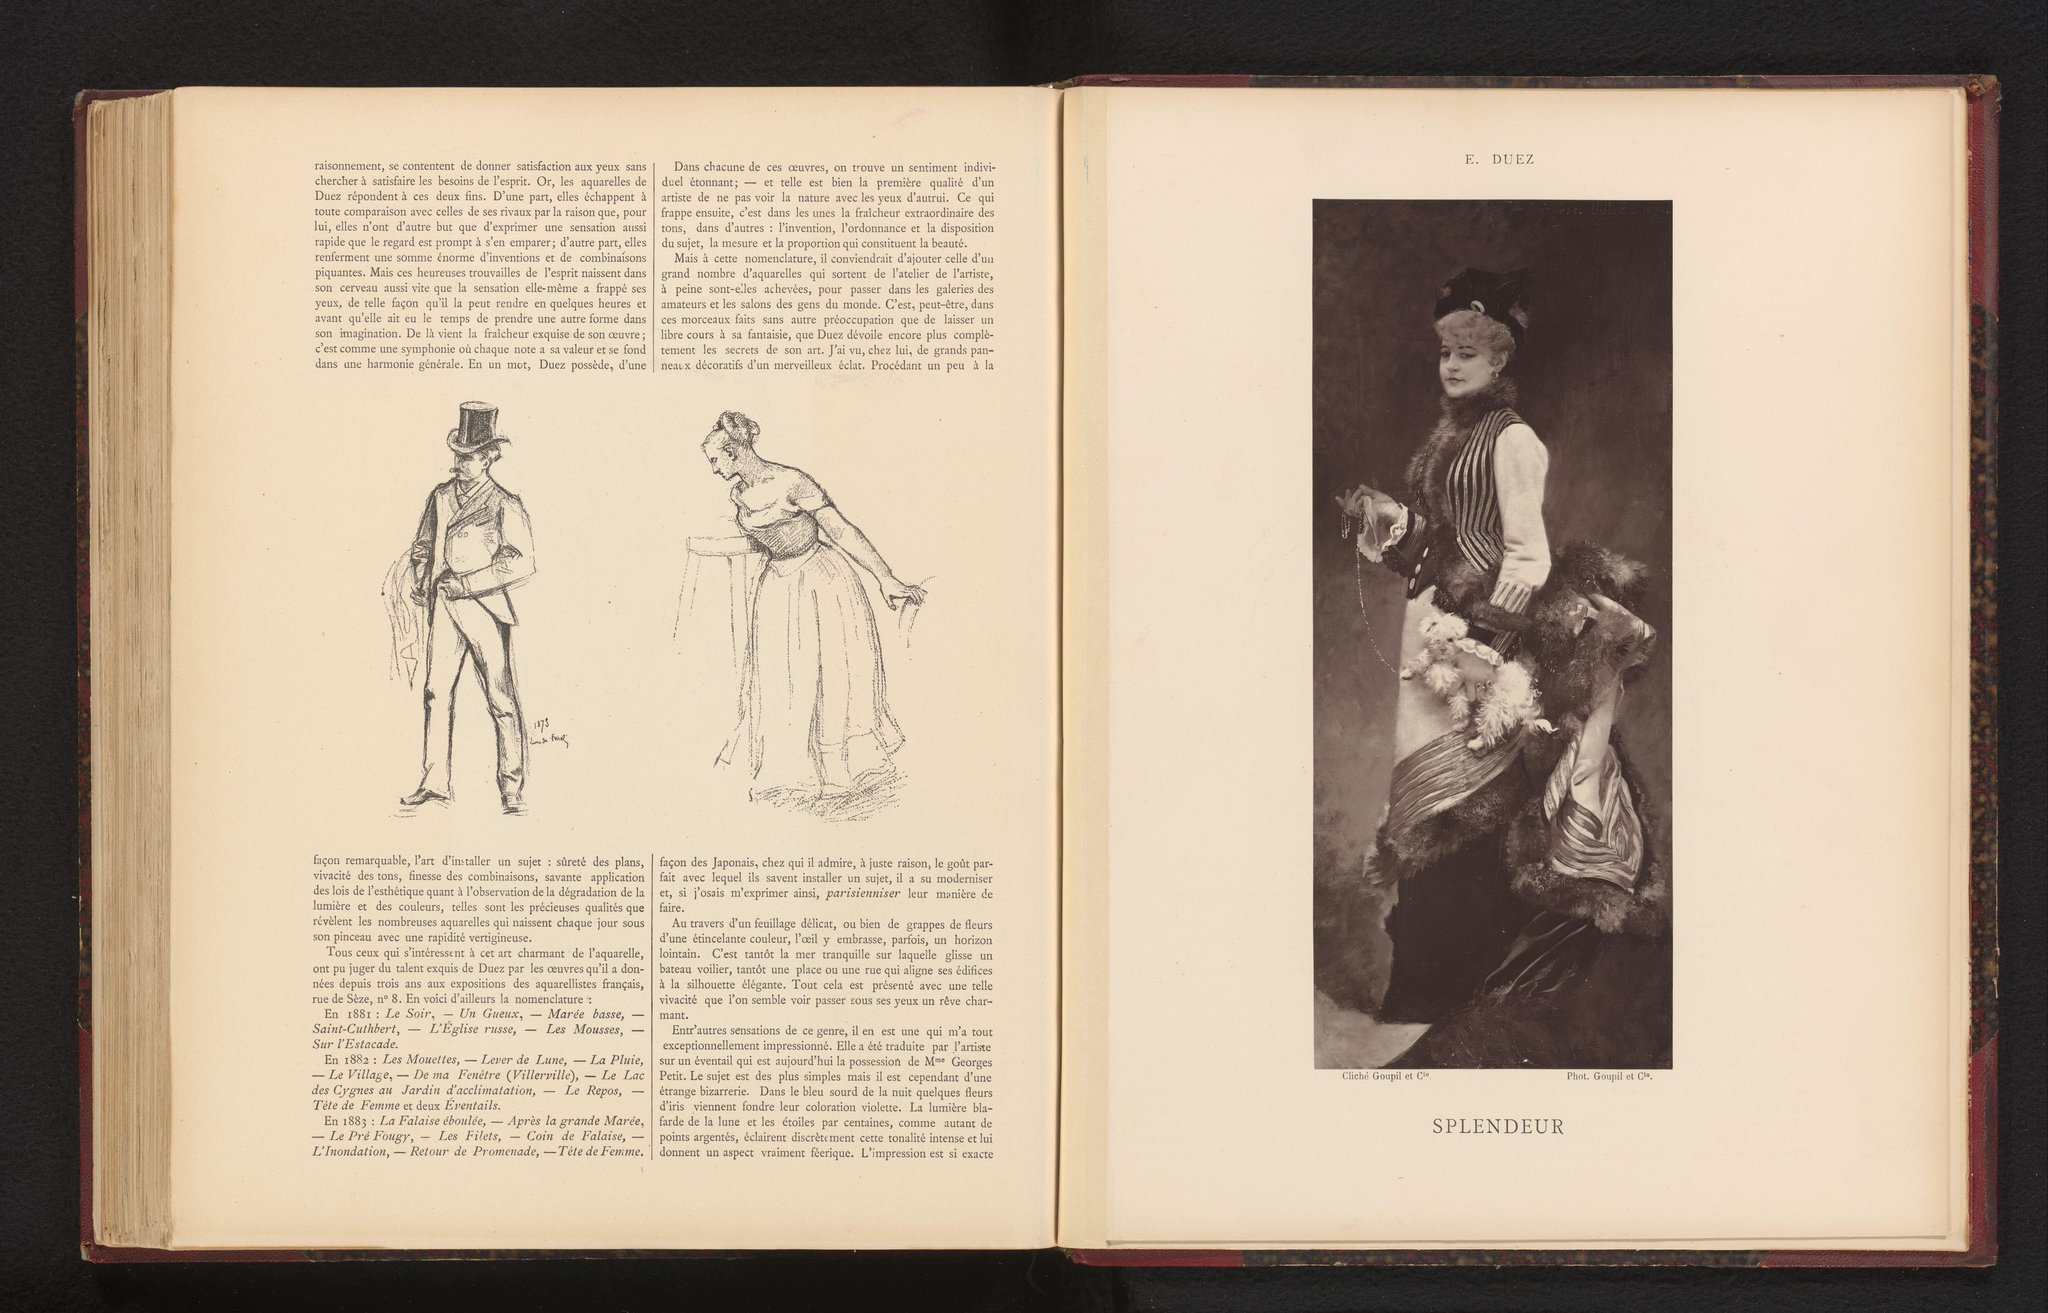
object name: photomechanical print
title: Splendeur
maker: ernest-ange duez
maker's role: painter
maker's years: 1843-1896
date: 1878-1883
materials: paper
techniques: woodburytype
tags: adult woman